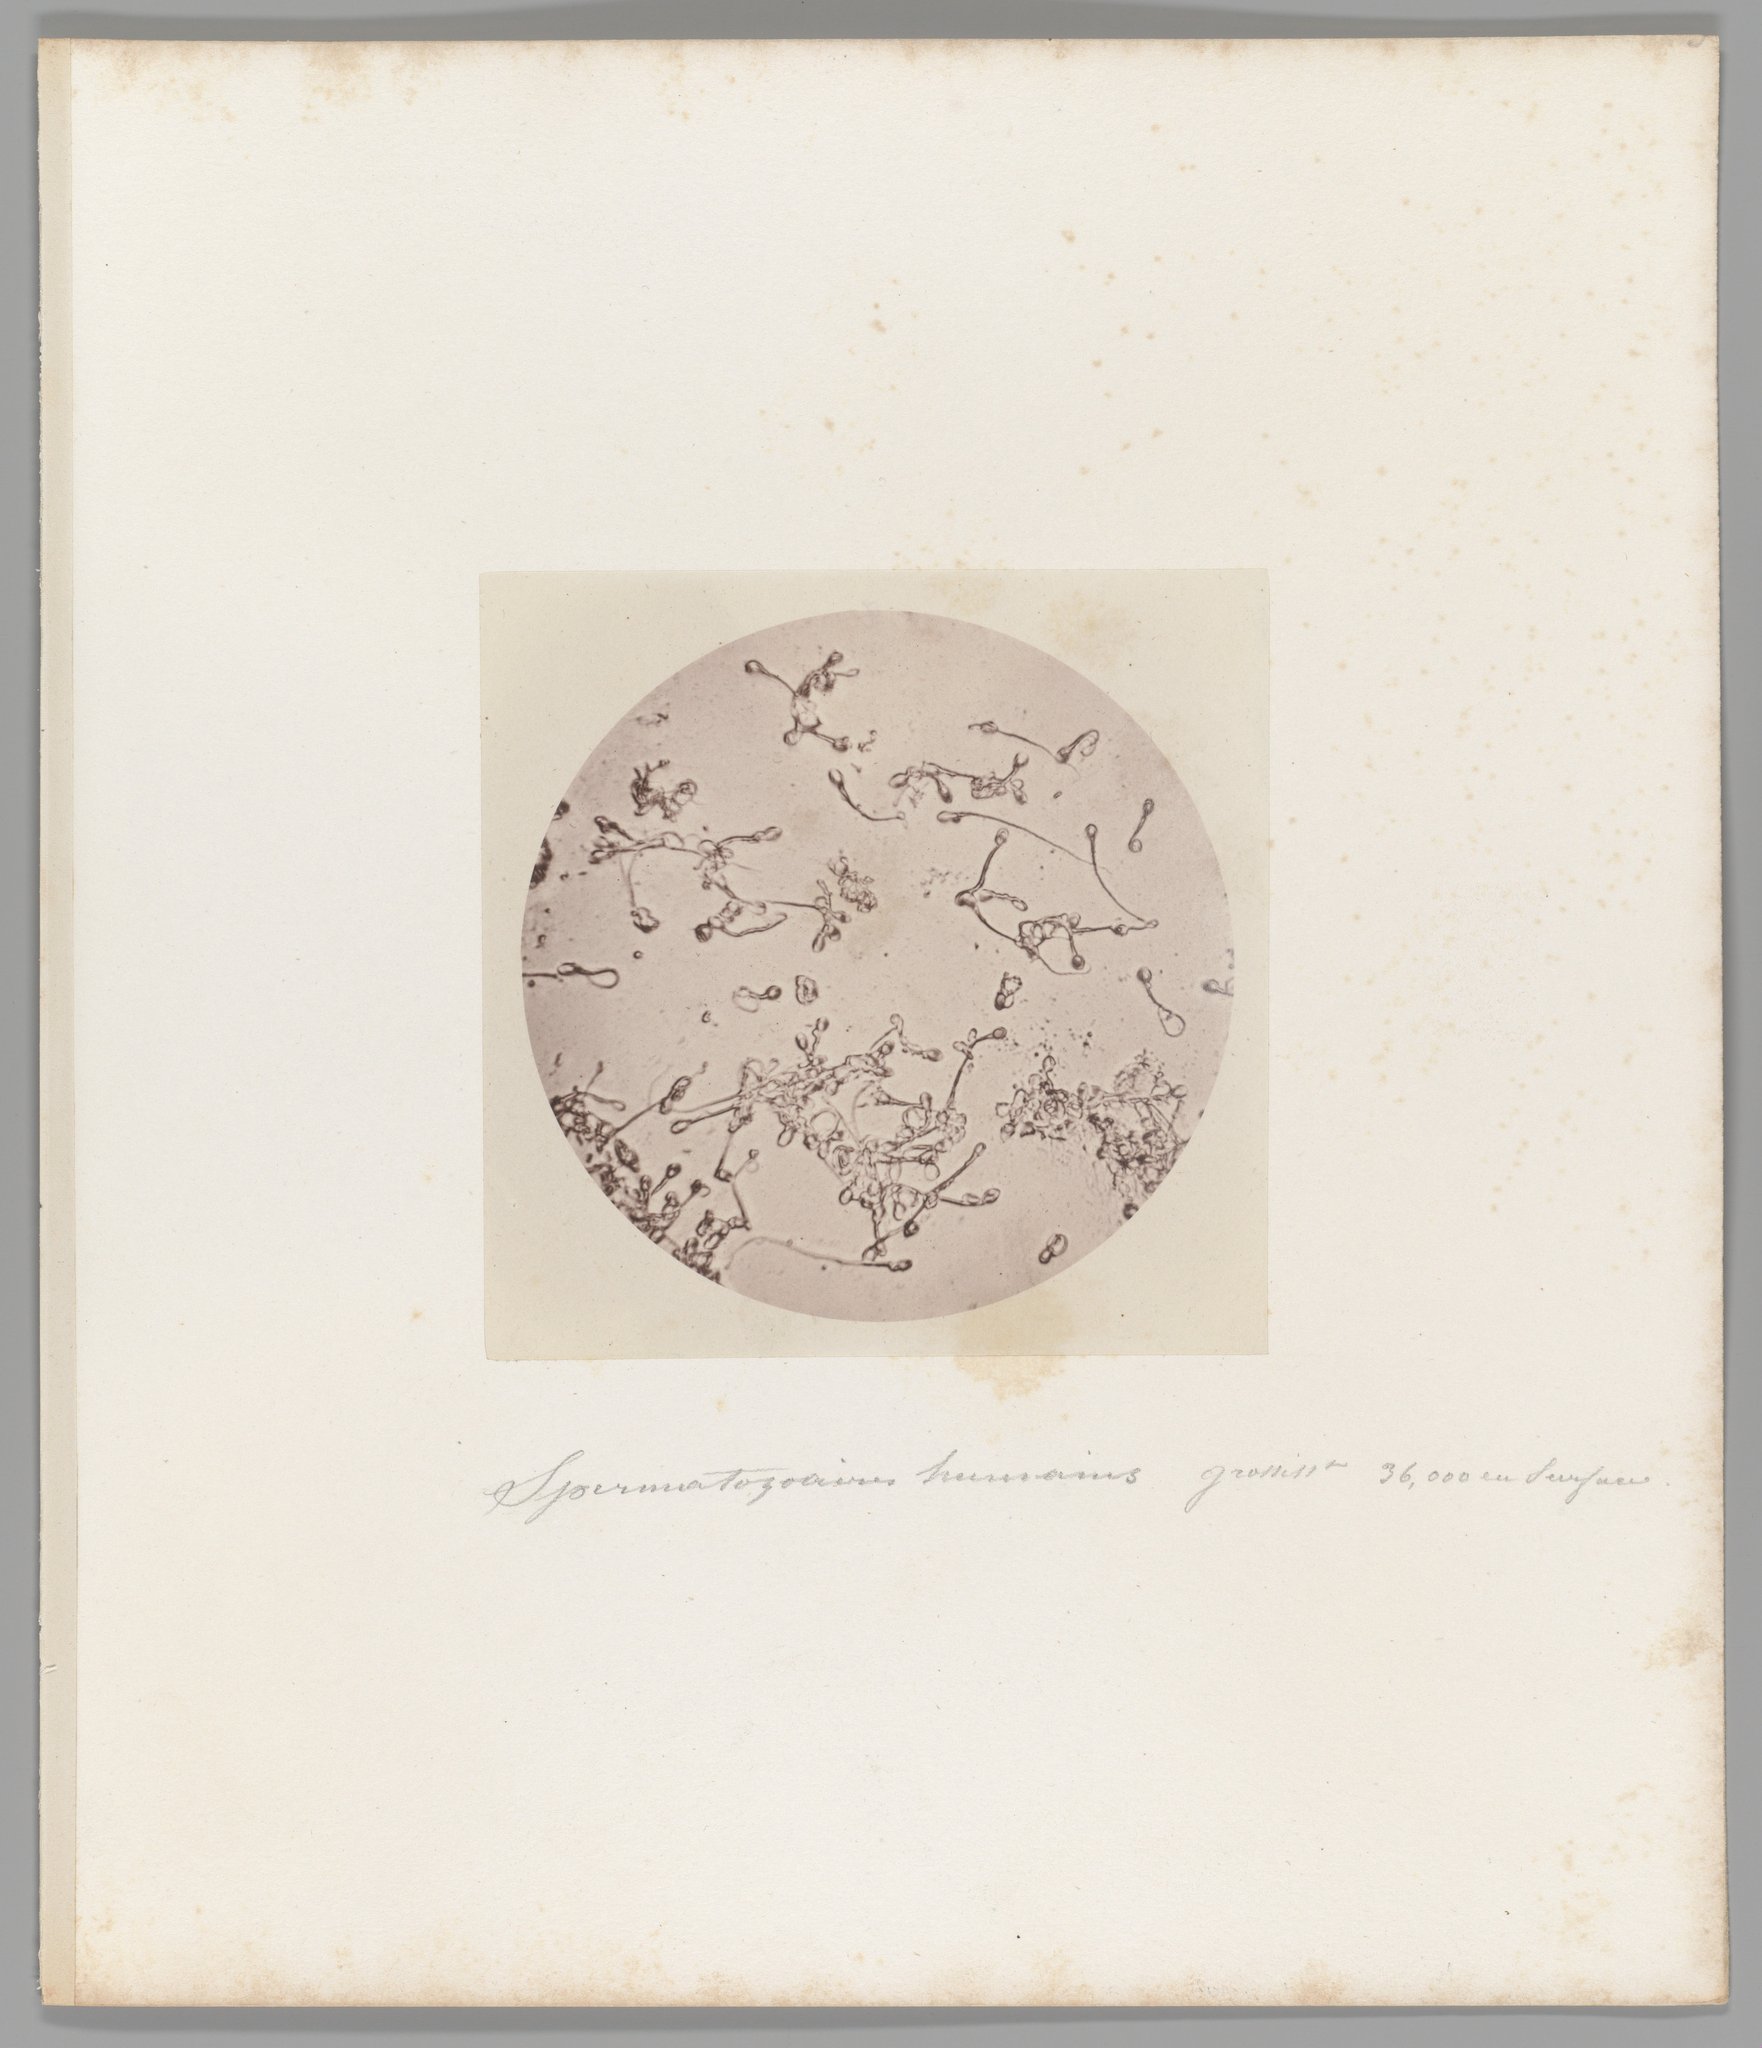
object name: photograph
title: [Untitled]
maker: auguste-adolphe bertsch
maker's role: artist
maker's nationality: french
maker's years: 1813-1871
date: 1853-1857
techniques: salted paper print